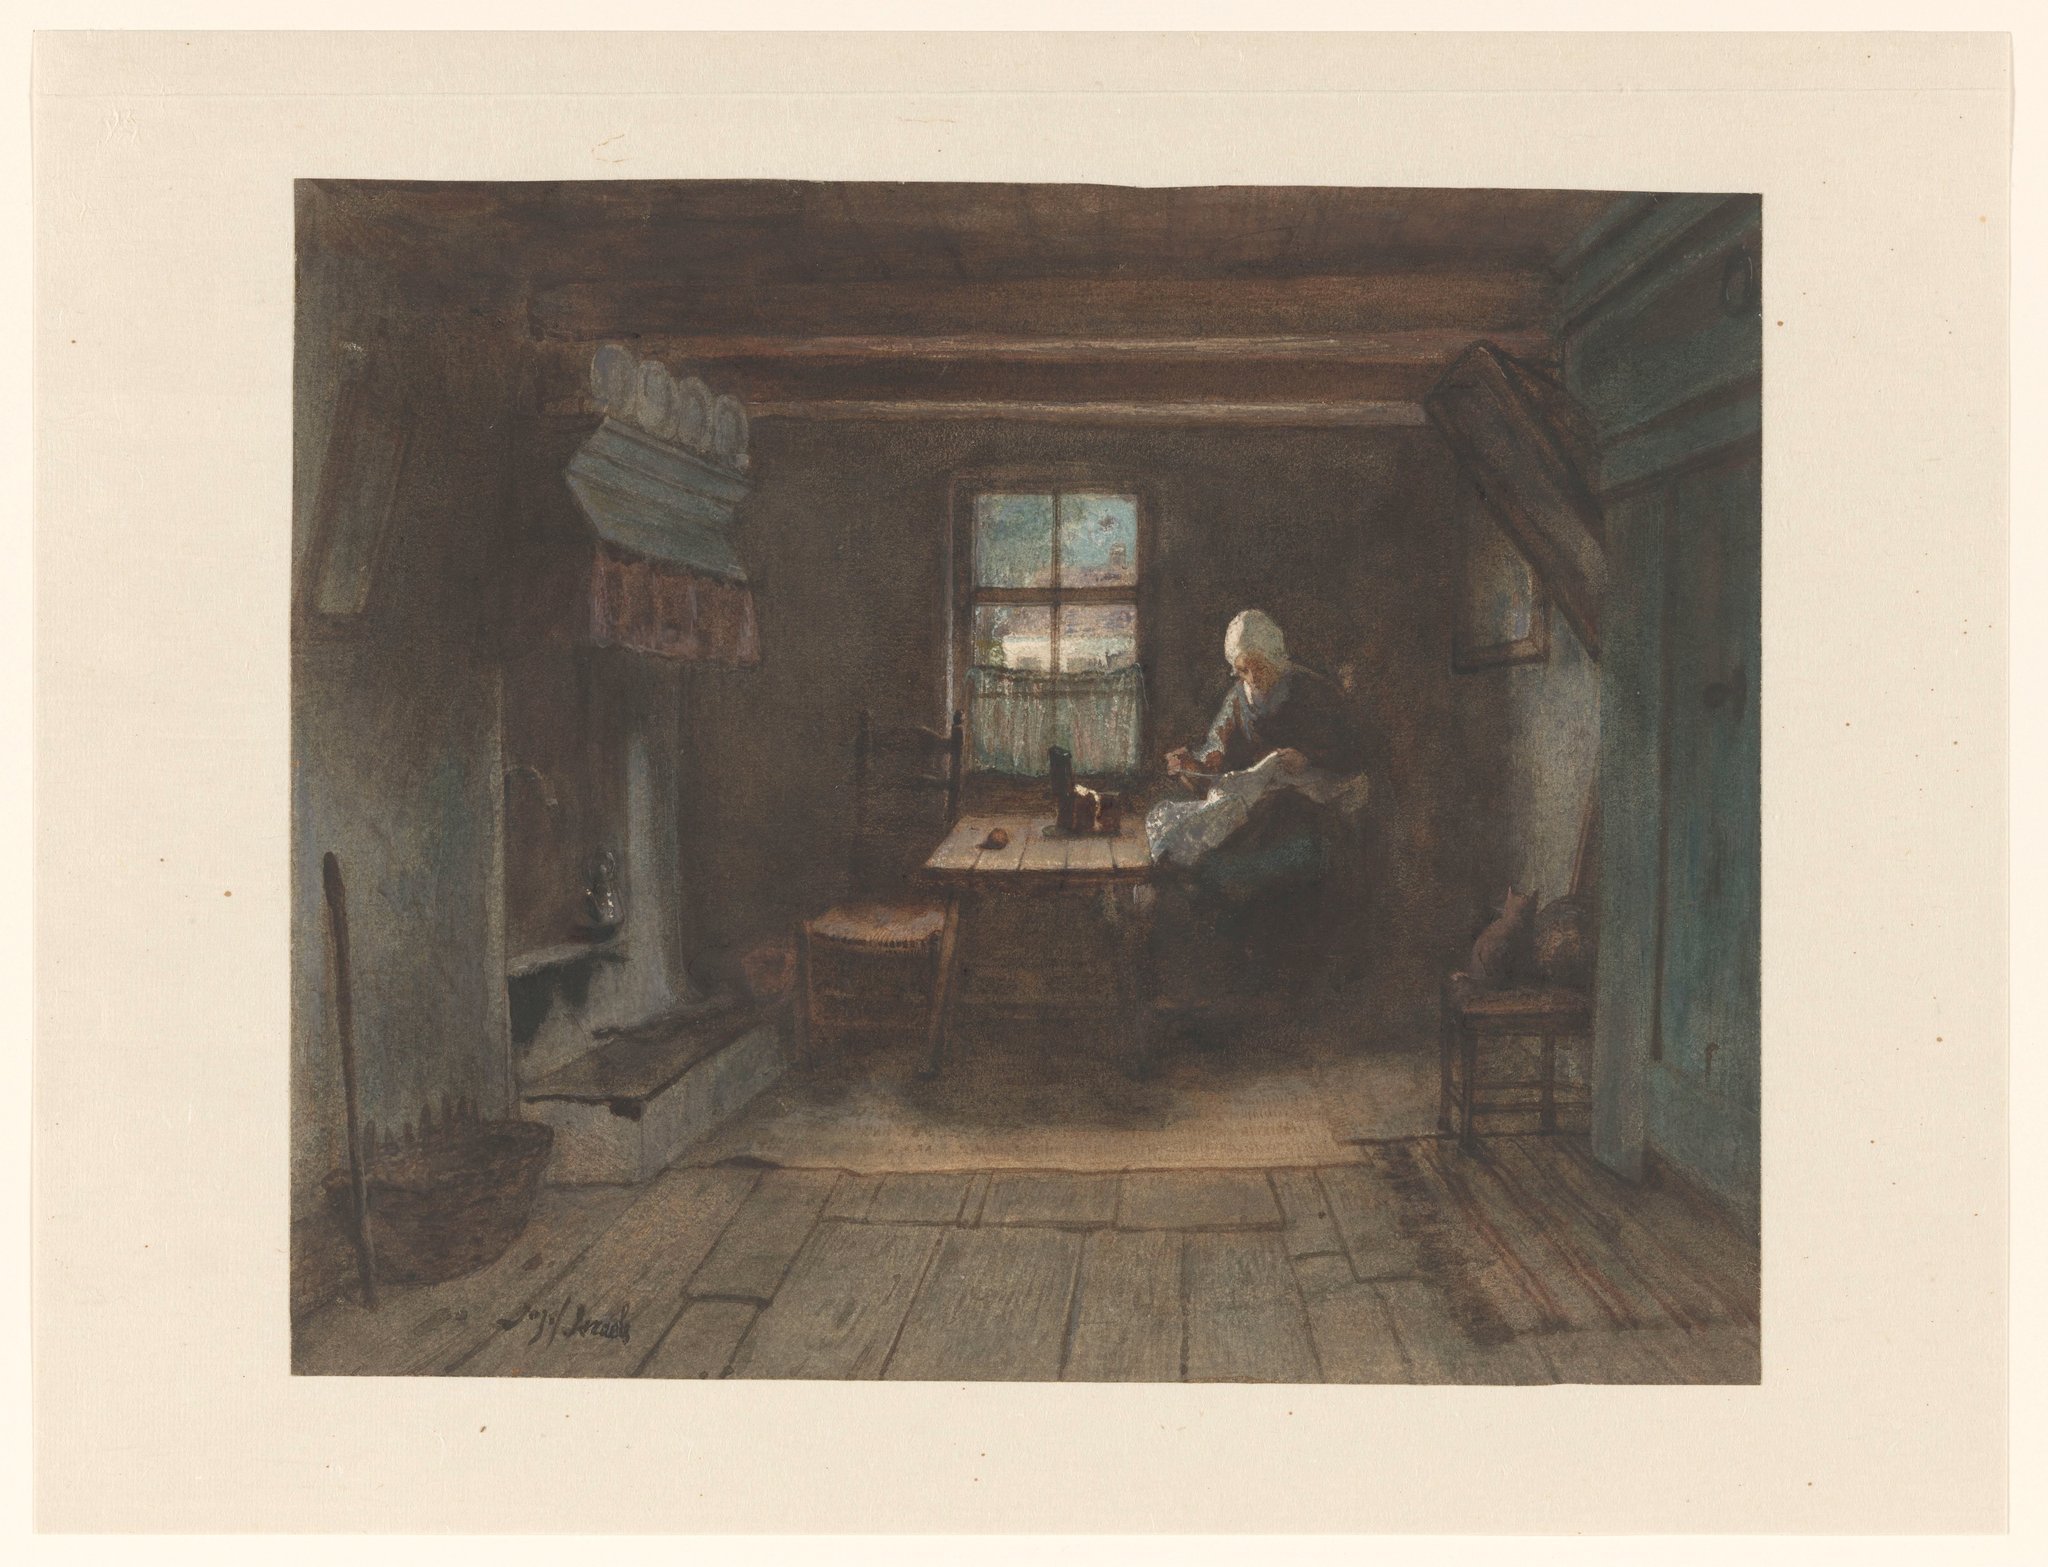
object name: drawing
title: Boerenbinnenhuis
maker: jozef israëls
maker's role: draughtsman, painter, print maker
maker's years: 1824-1911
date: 1834-1911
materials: paper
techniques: brush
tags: communal rooms, (other forms of) needlework, e.g.: crocheting, knitting, embroidering, farm (building) - aa - civic architecture: inside